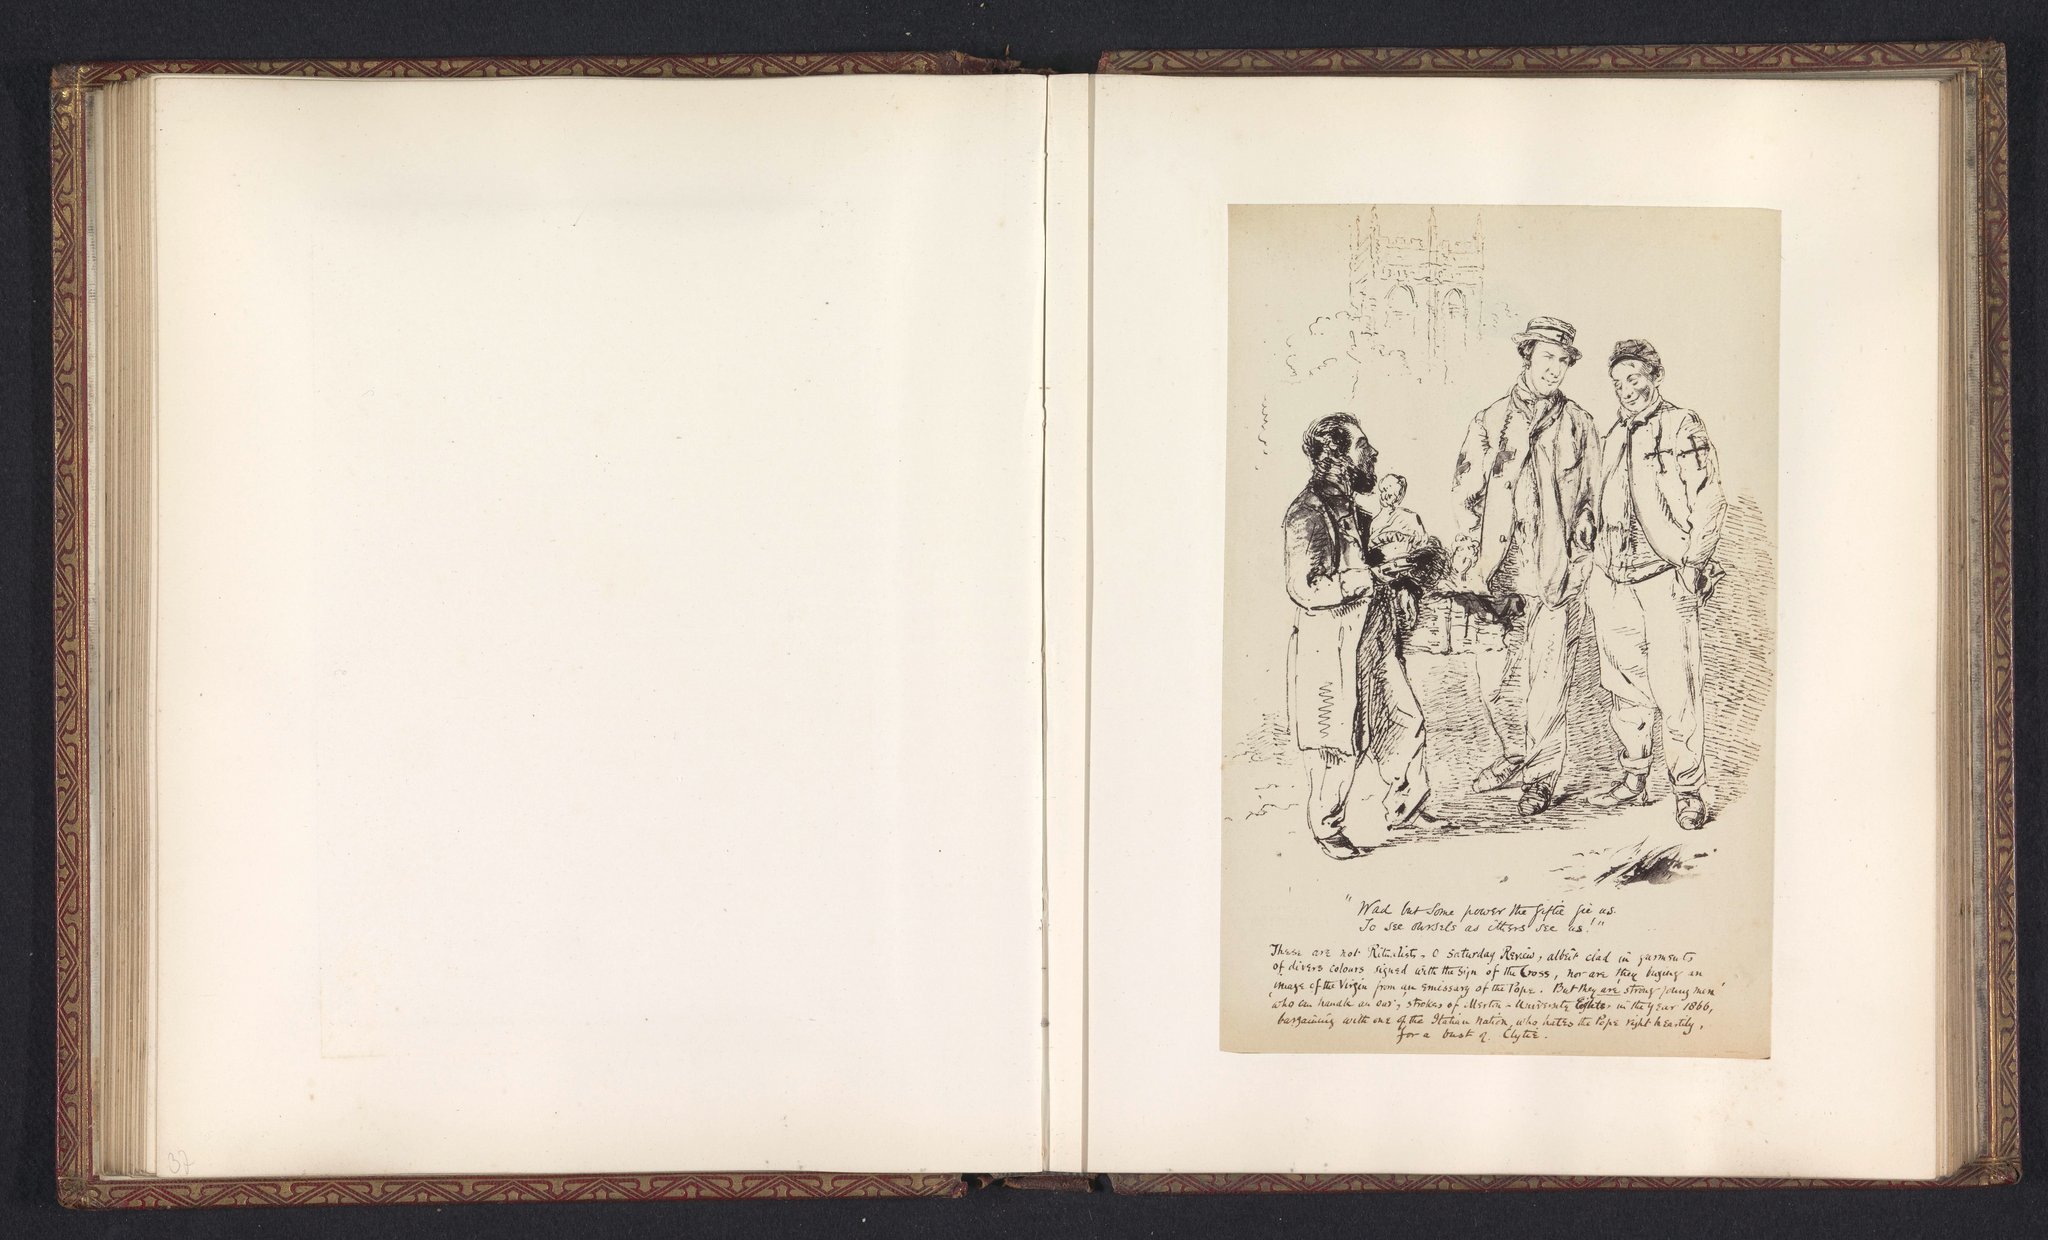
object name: reproduction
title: Fotoreproductie van een tekening, voorstellende twee studenten in roeikleding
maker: Anonymous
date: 1855-1866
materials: photographic support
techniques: albumen print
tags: caricatures (human types), clothes for special purposes, student life, rowing, canoeing, etc. (sport)